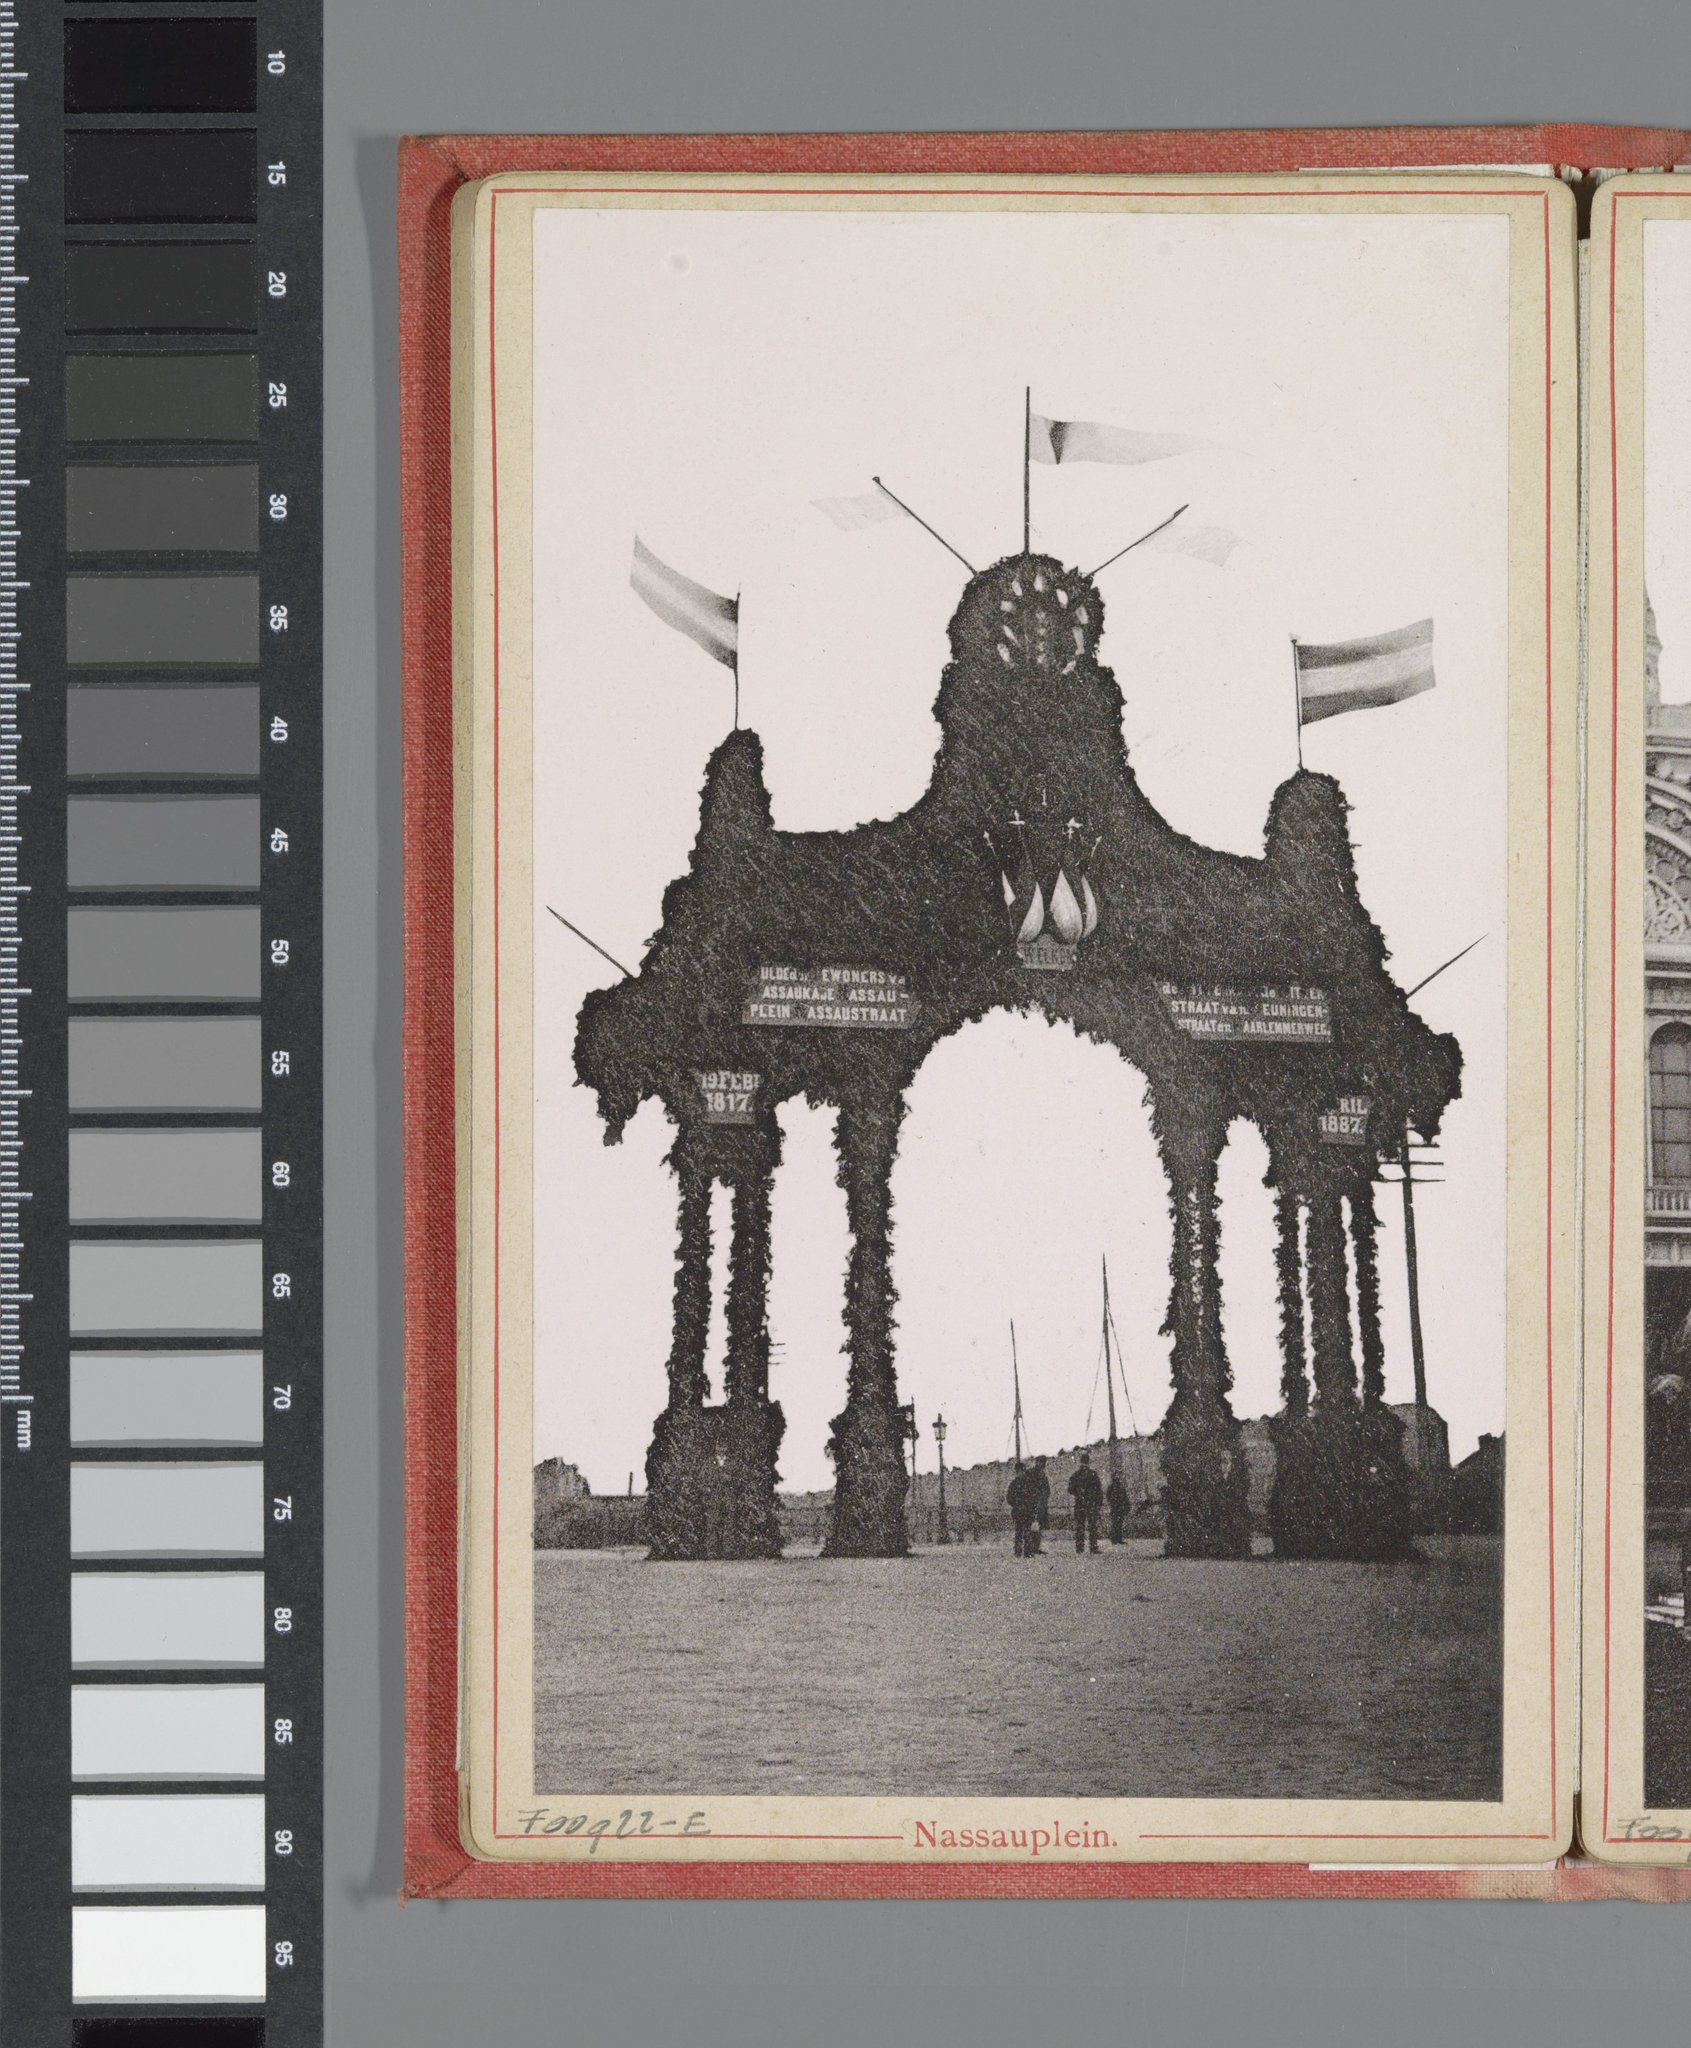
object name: photograph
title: Nassauplein.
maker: Anonymous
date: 1804-1887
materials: cardboard, paper, ink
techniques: photograph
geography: amsterdam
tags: gate, entrance, prospect of city, town panorama, silhouette of city, amsterdam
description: Onderdeel van Fotoalbum met opnames van de Aprilfeesten in 1887 te Amsterdam.